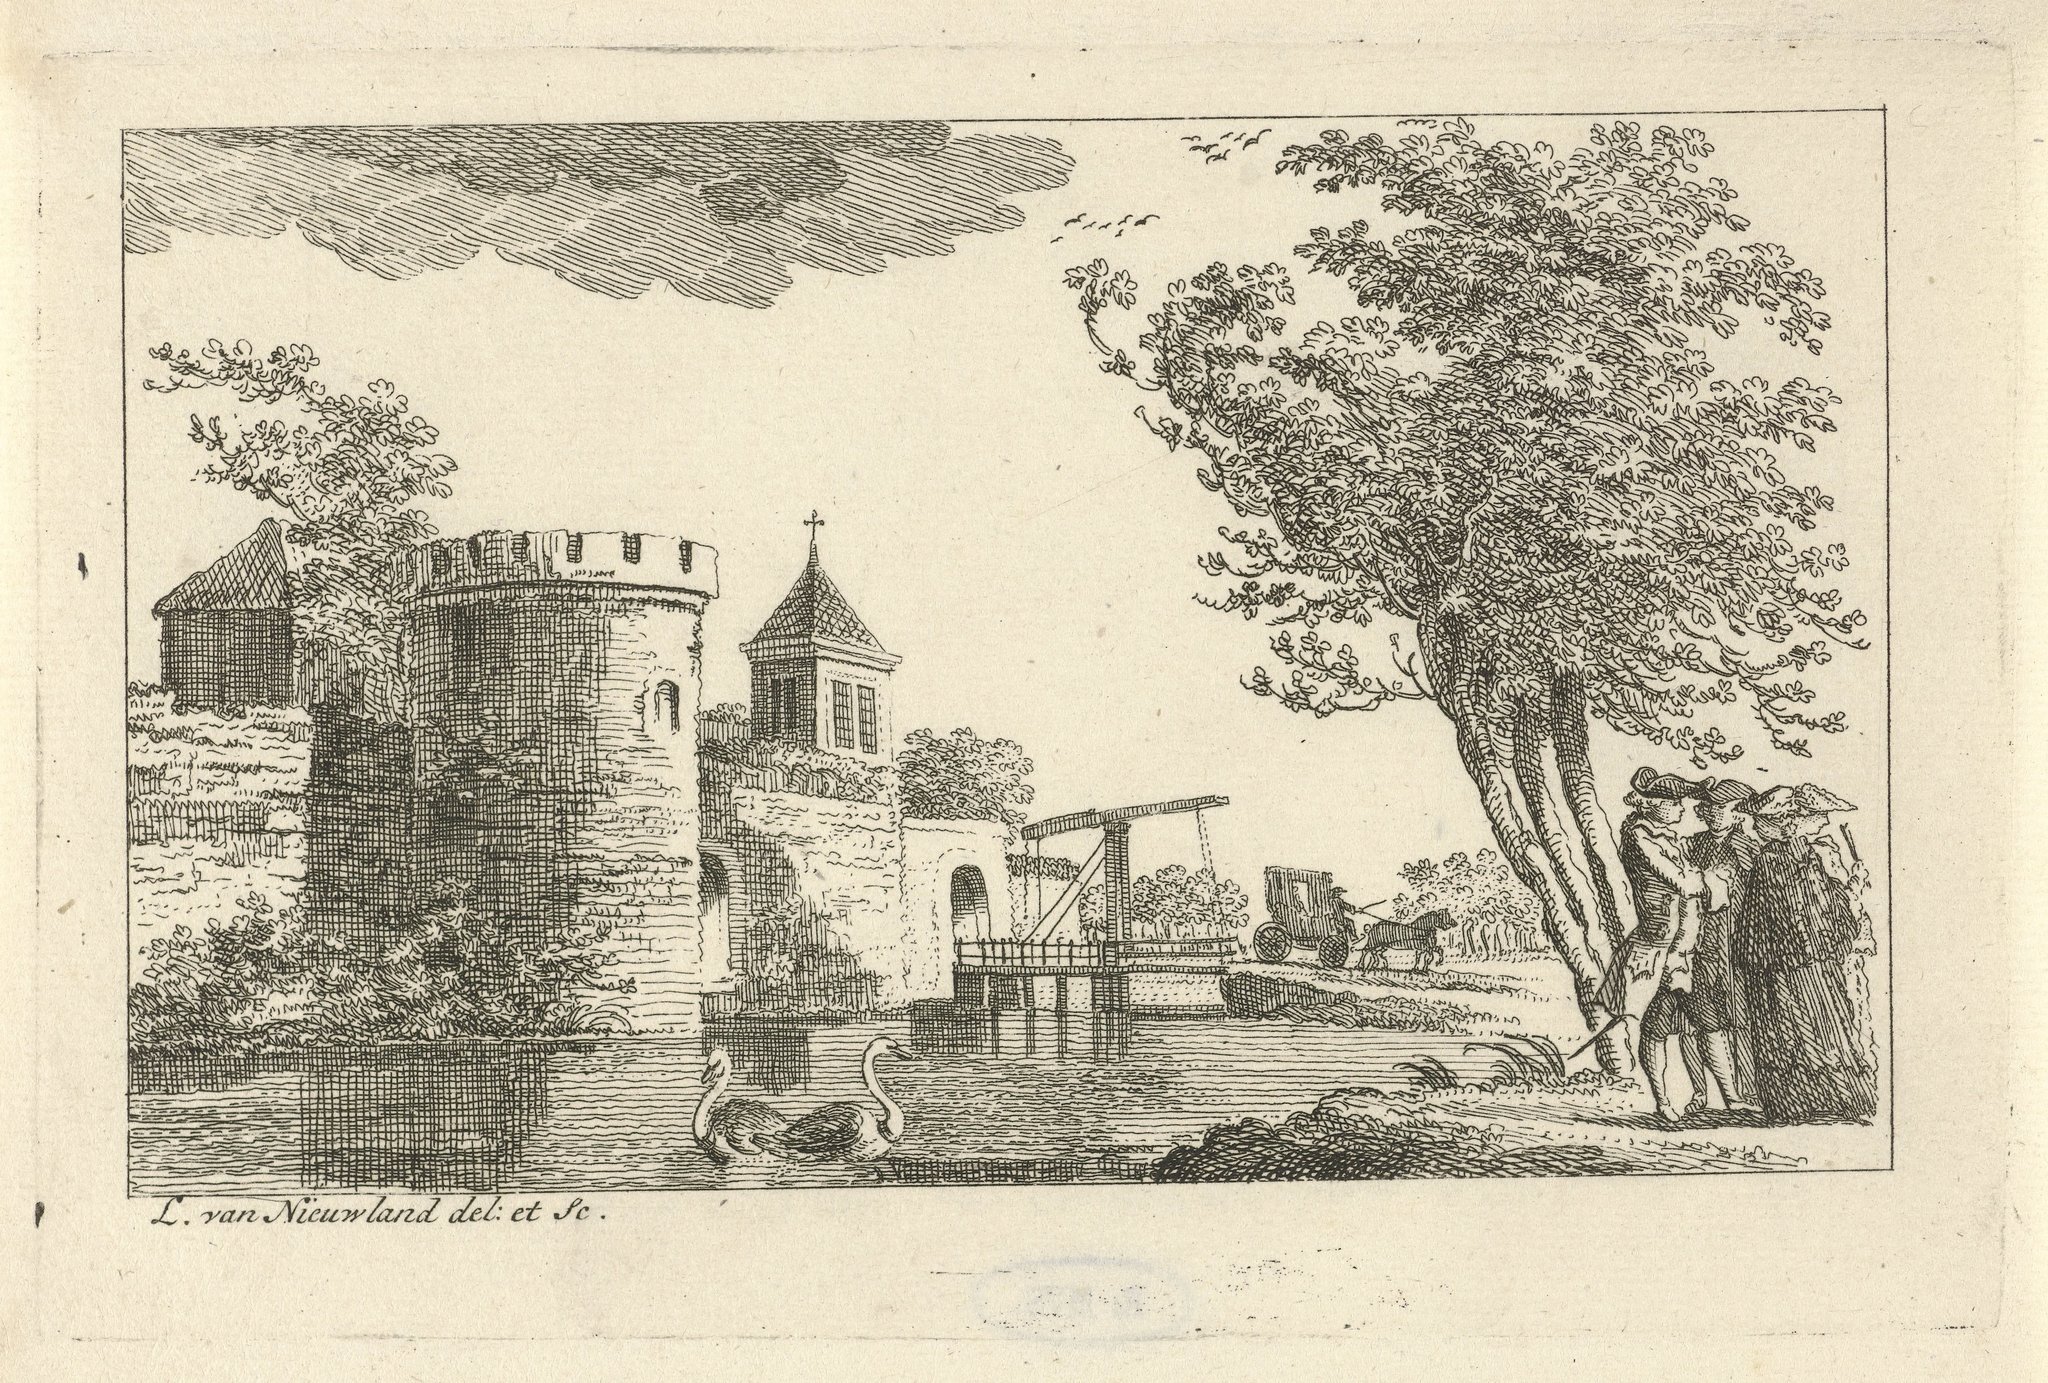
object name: print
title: Twaalf Hollandse landschappen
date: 1763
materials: paper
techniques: etching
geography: amsterdam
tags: drawbridge ~ fortified city (+ variant), castle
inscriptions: collector's mark: Lugt 2228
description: Landschap met vesting, in de verte rijdt een koets over een ophaalbrug. Rechts op de voorgrond staan figuren bij een boom.